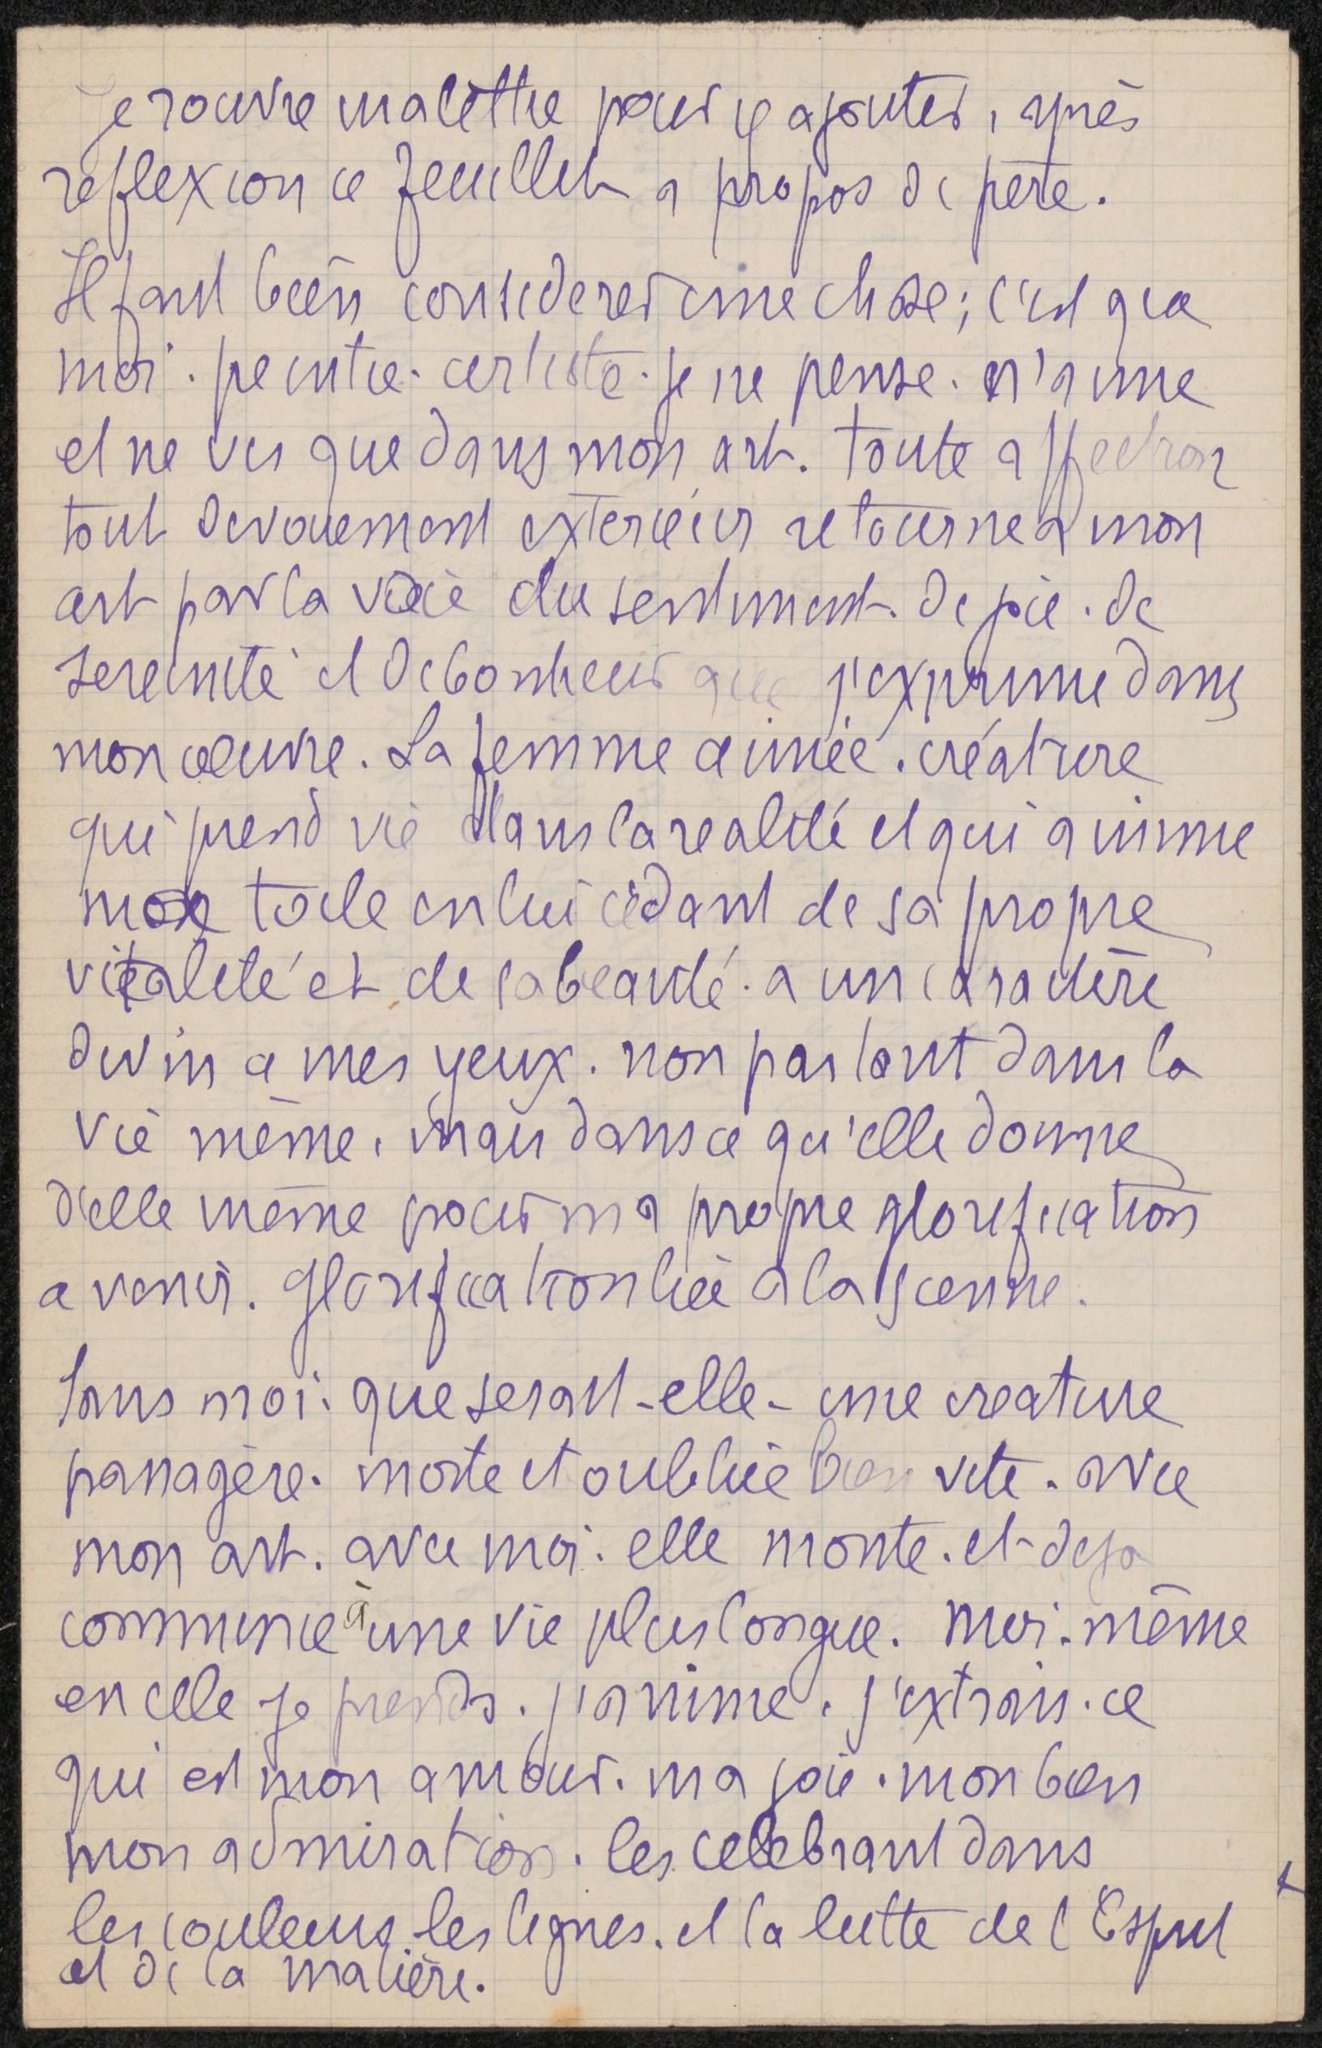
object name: letter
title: Brief aan anoniem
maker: émile bernard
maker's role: print maker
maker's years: 1868-1941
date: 1878-1941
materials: ink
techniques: pen, writing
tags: héloïse bernard-bodin, emile ernest bernard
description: Betreft een fragment van een brief, waarschijnlijk gericht aan Emile Ernest Bernard en Héloïse Bernard-Bodin